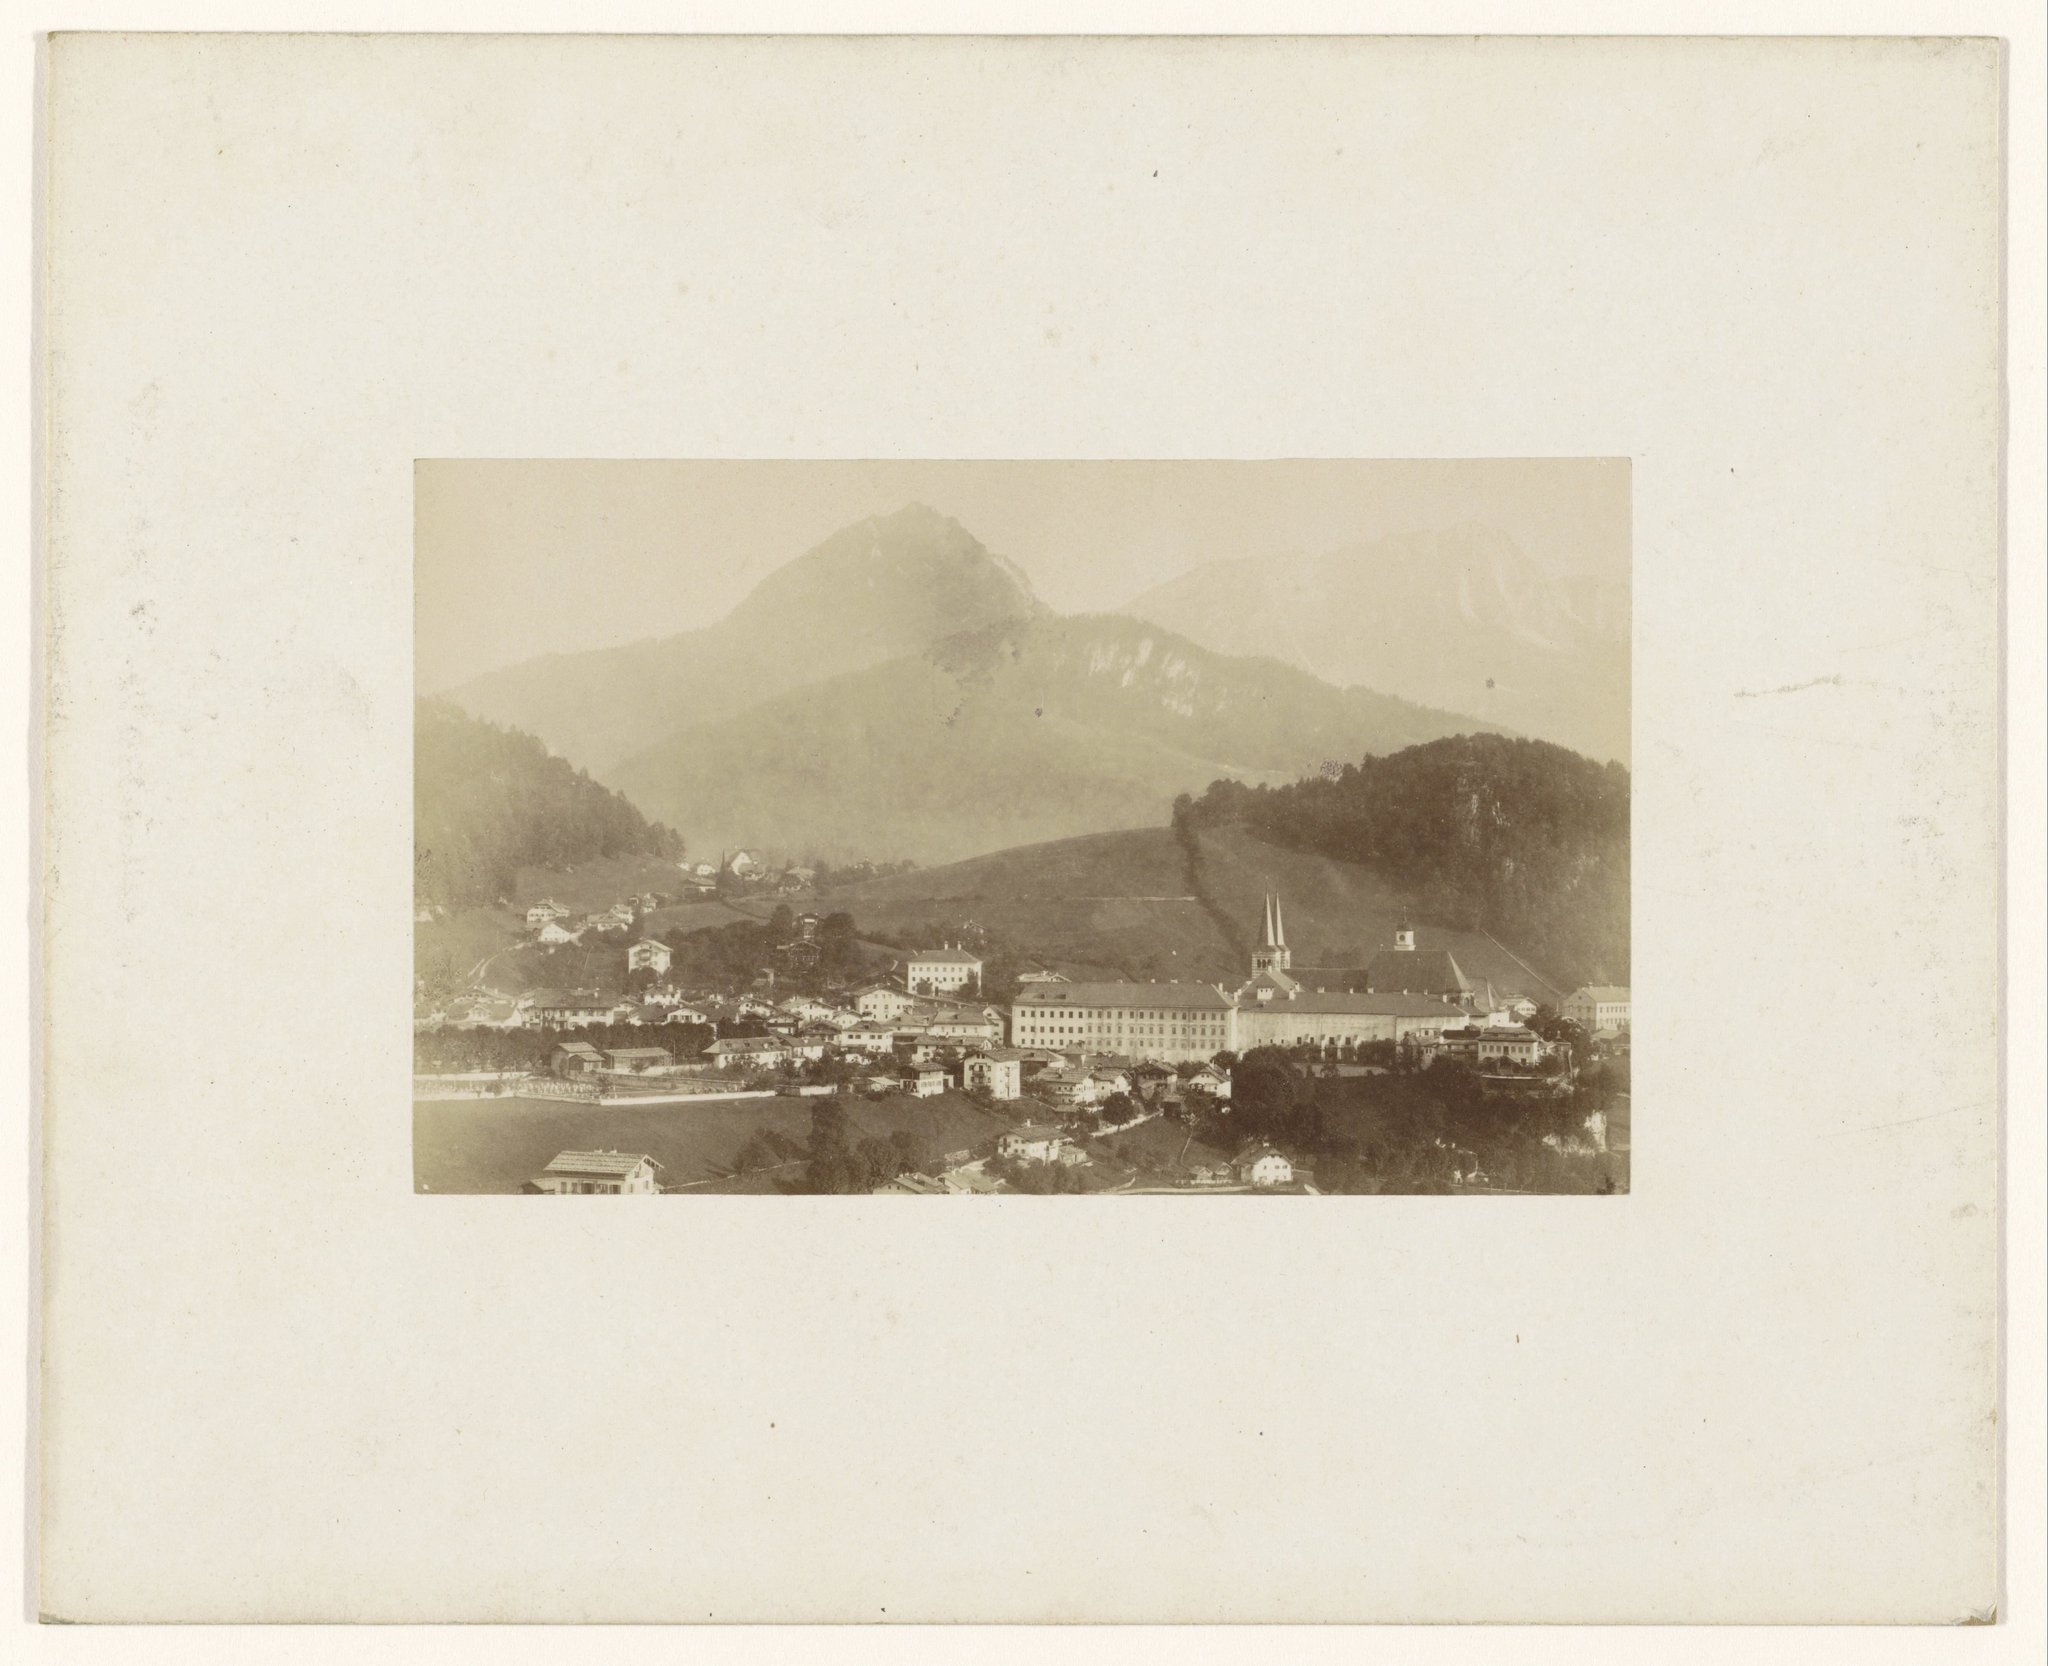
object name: photograph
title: Gezicht op Berchtesgaden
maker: Anonymous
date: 1860-1900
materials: cardboard, paper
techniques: albumen print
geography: berchtesgaden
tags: prospect of village, silhouette of village, mountains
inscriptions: inscription: ‘Berchtesgaden’